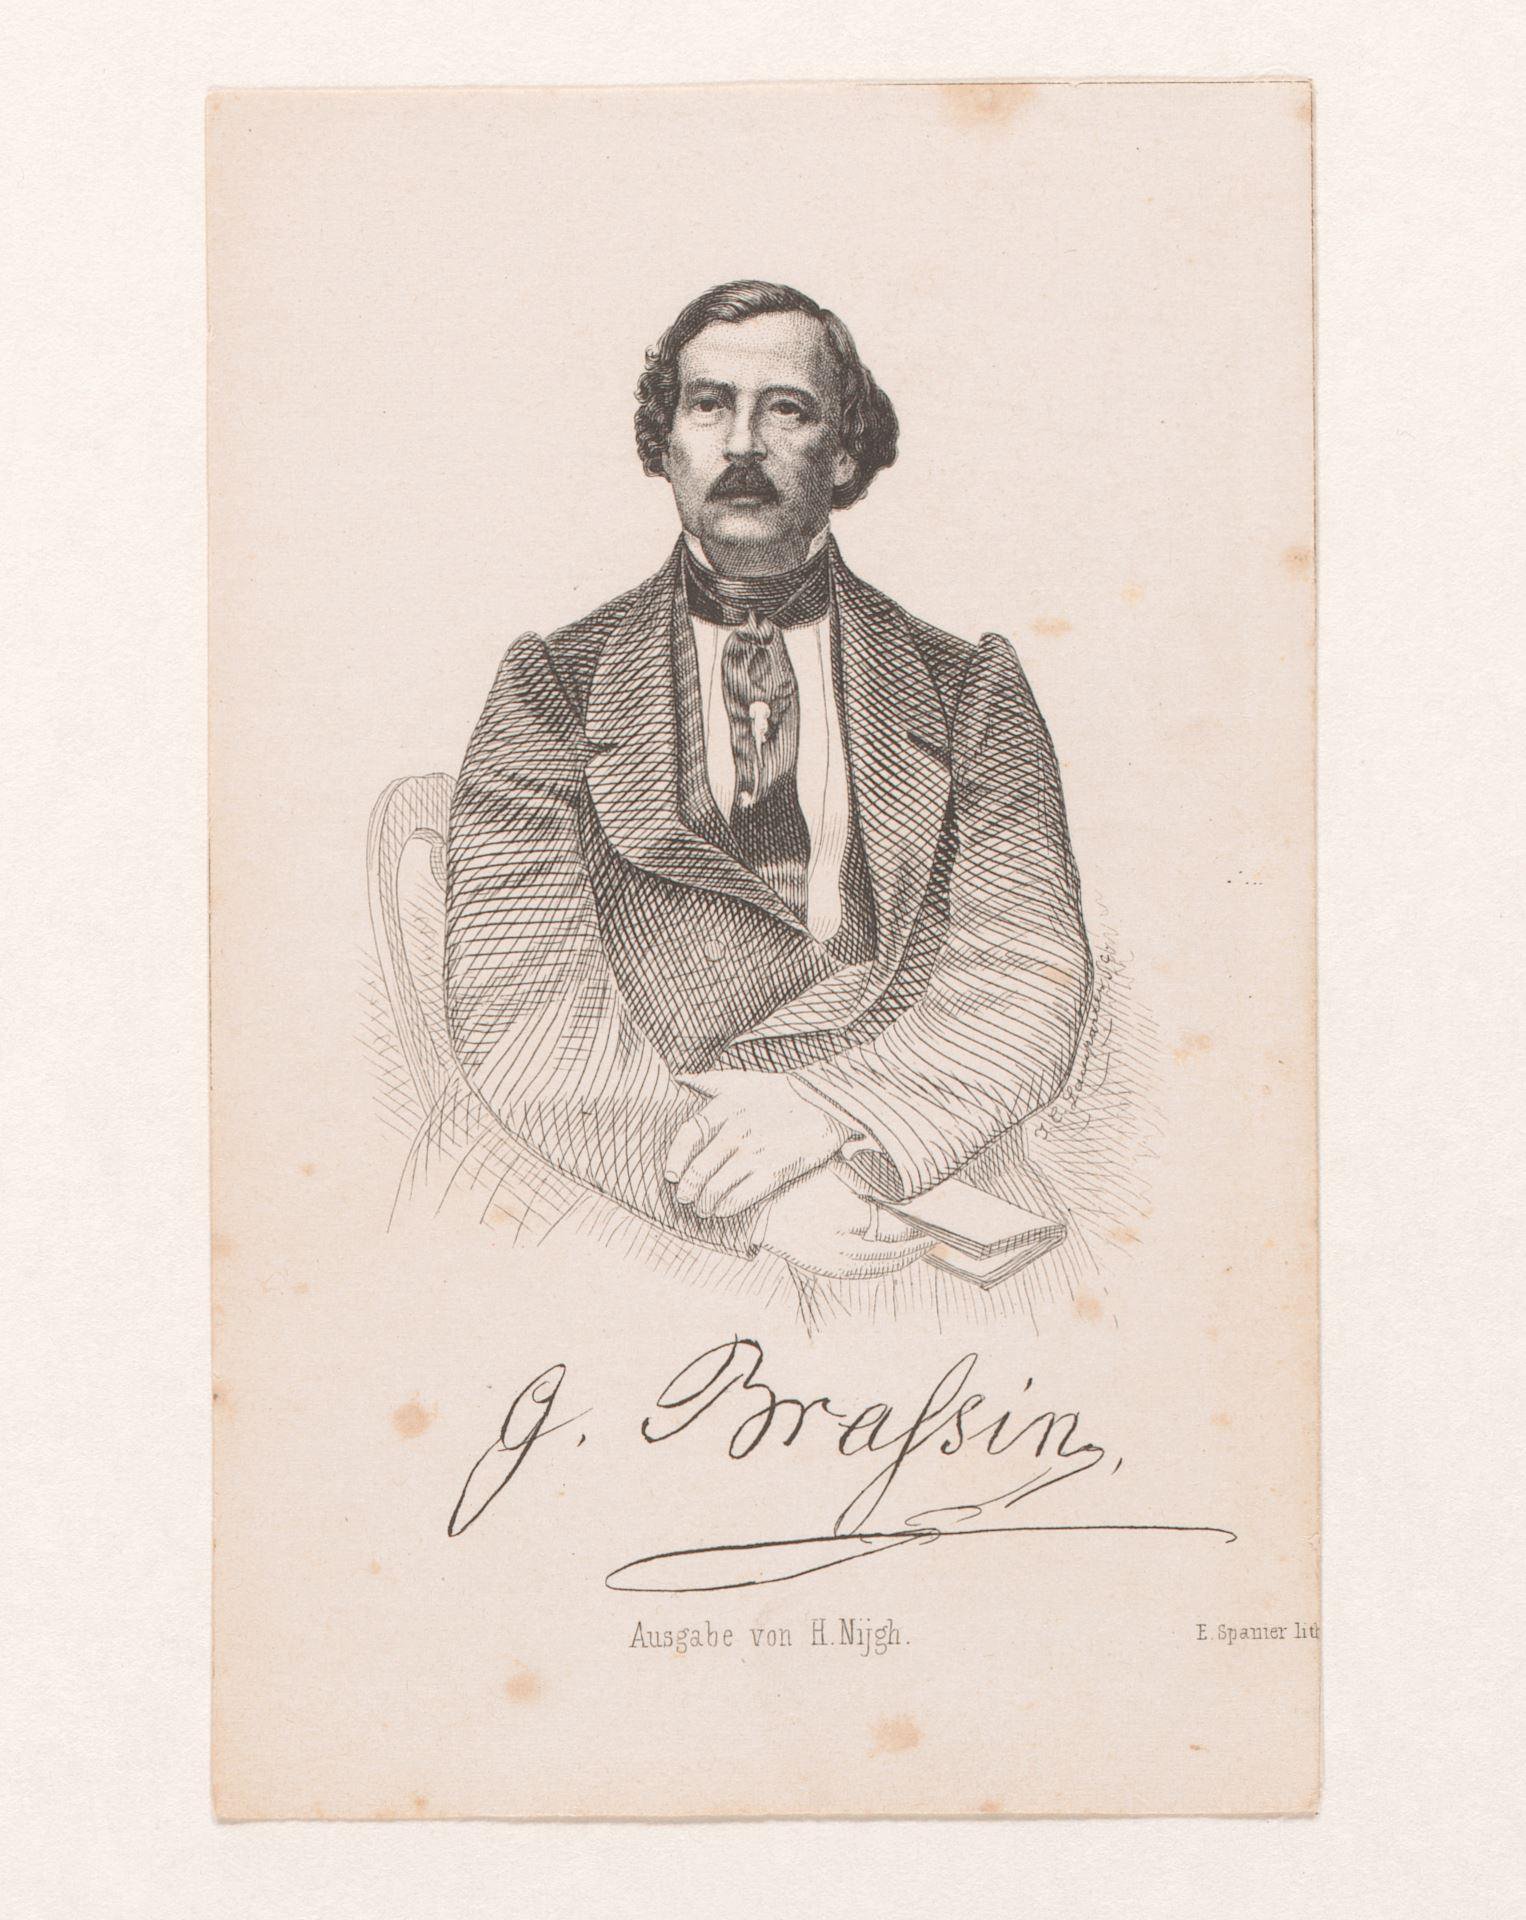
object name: print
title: Portret van G. Brassin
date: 1831-1863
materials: paper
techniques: lithograph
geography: the hague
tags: historical persons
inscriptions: collector's mark: Lugt 2228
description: Onder het portret de signatuur van de geportretteerde.